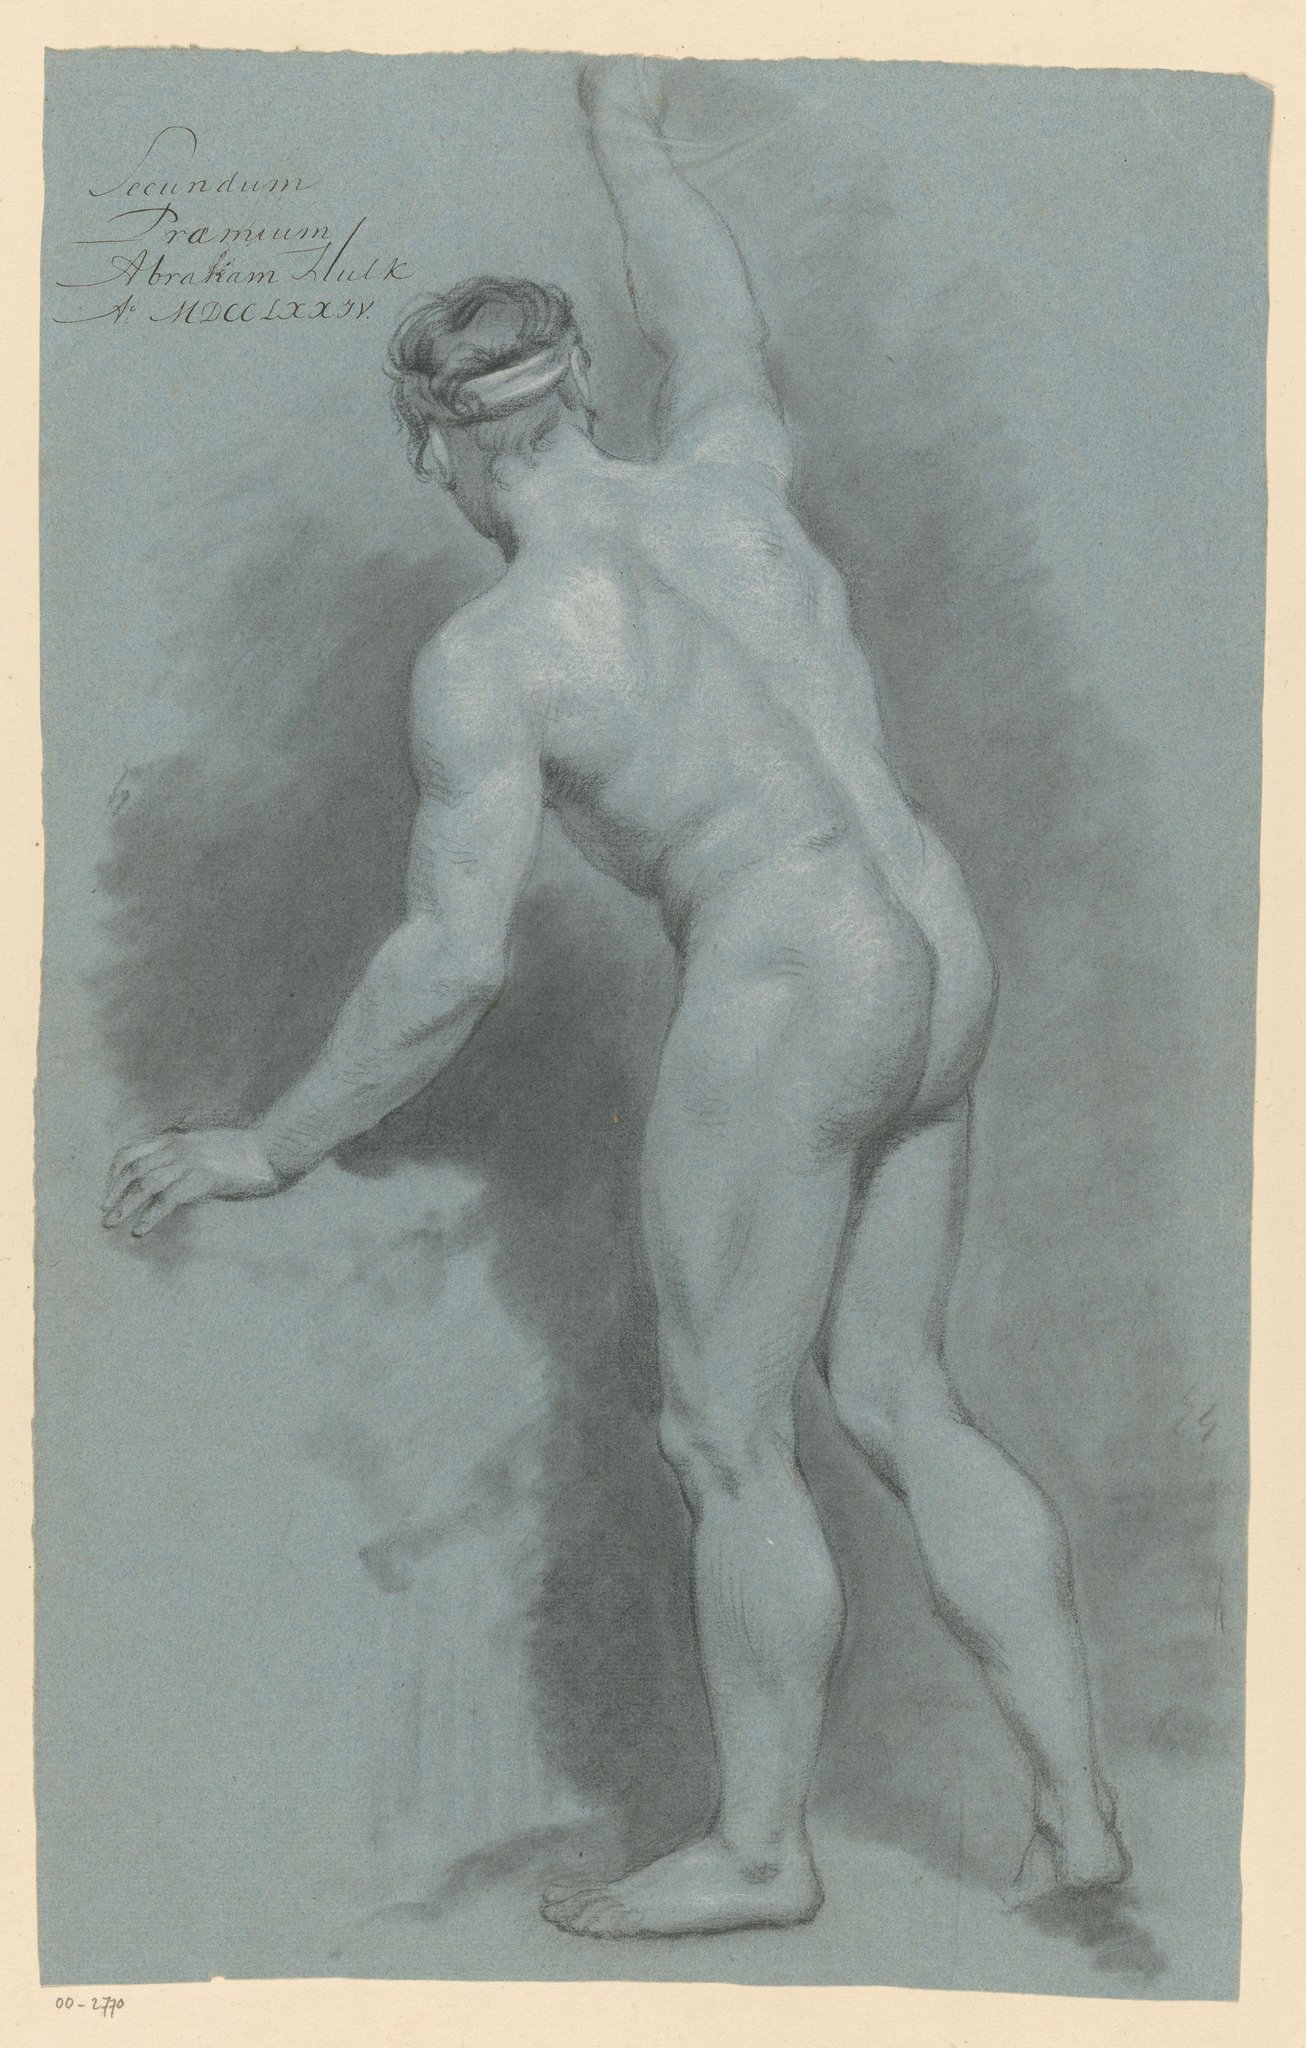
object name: drawing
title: Staand mannelijk naakt, op de rug gezien (2e prijs 1774)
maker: abraham pietersz. hulk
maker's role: draughtsman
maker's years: 1752-1809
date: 1774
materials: chalk, paper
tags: standing figure (+ nude human being)